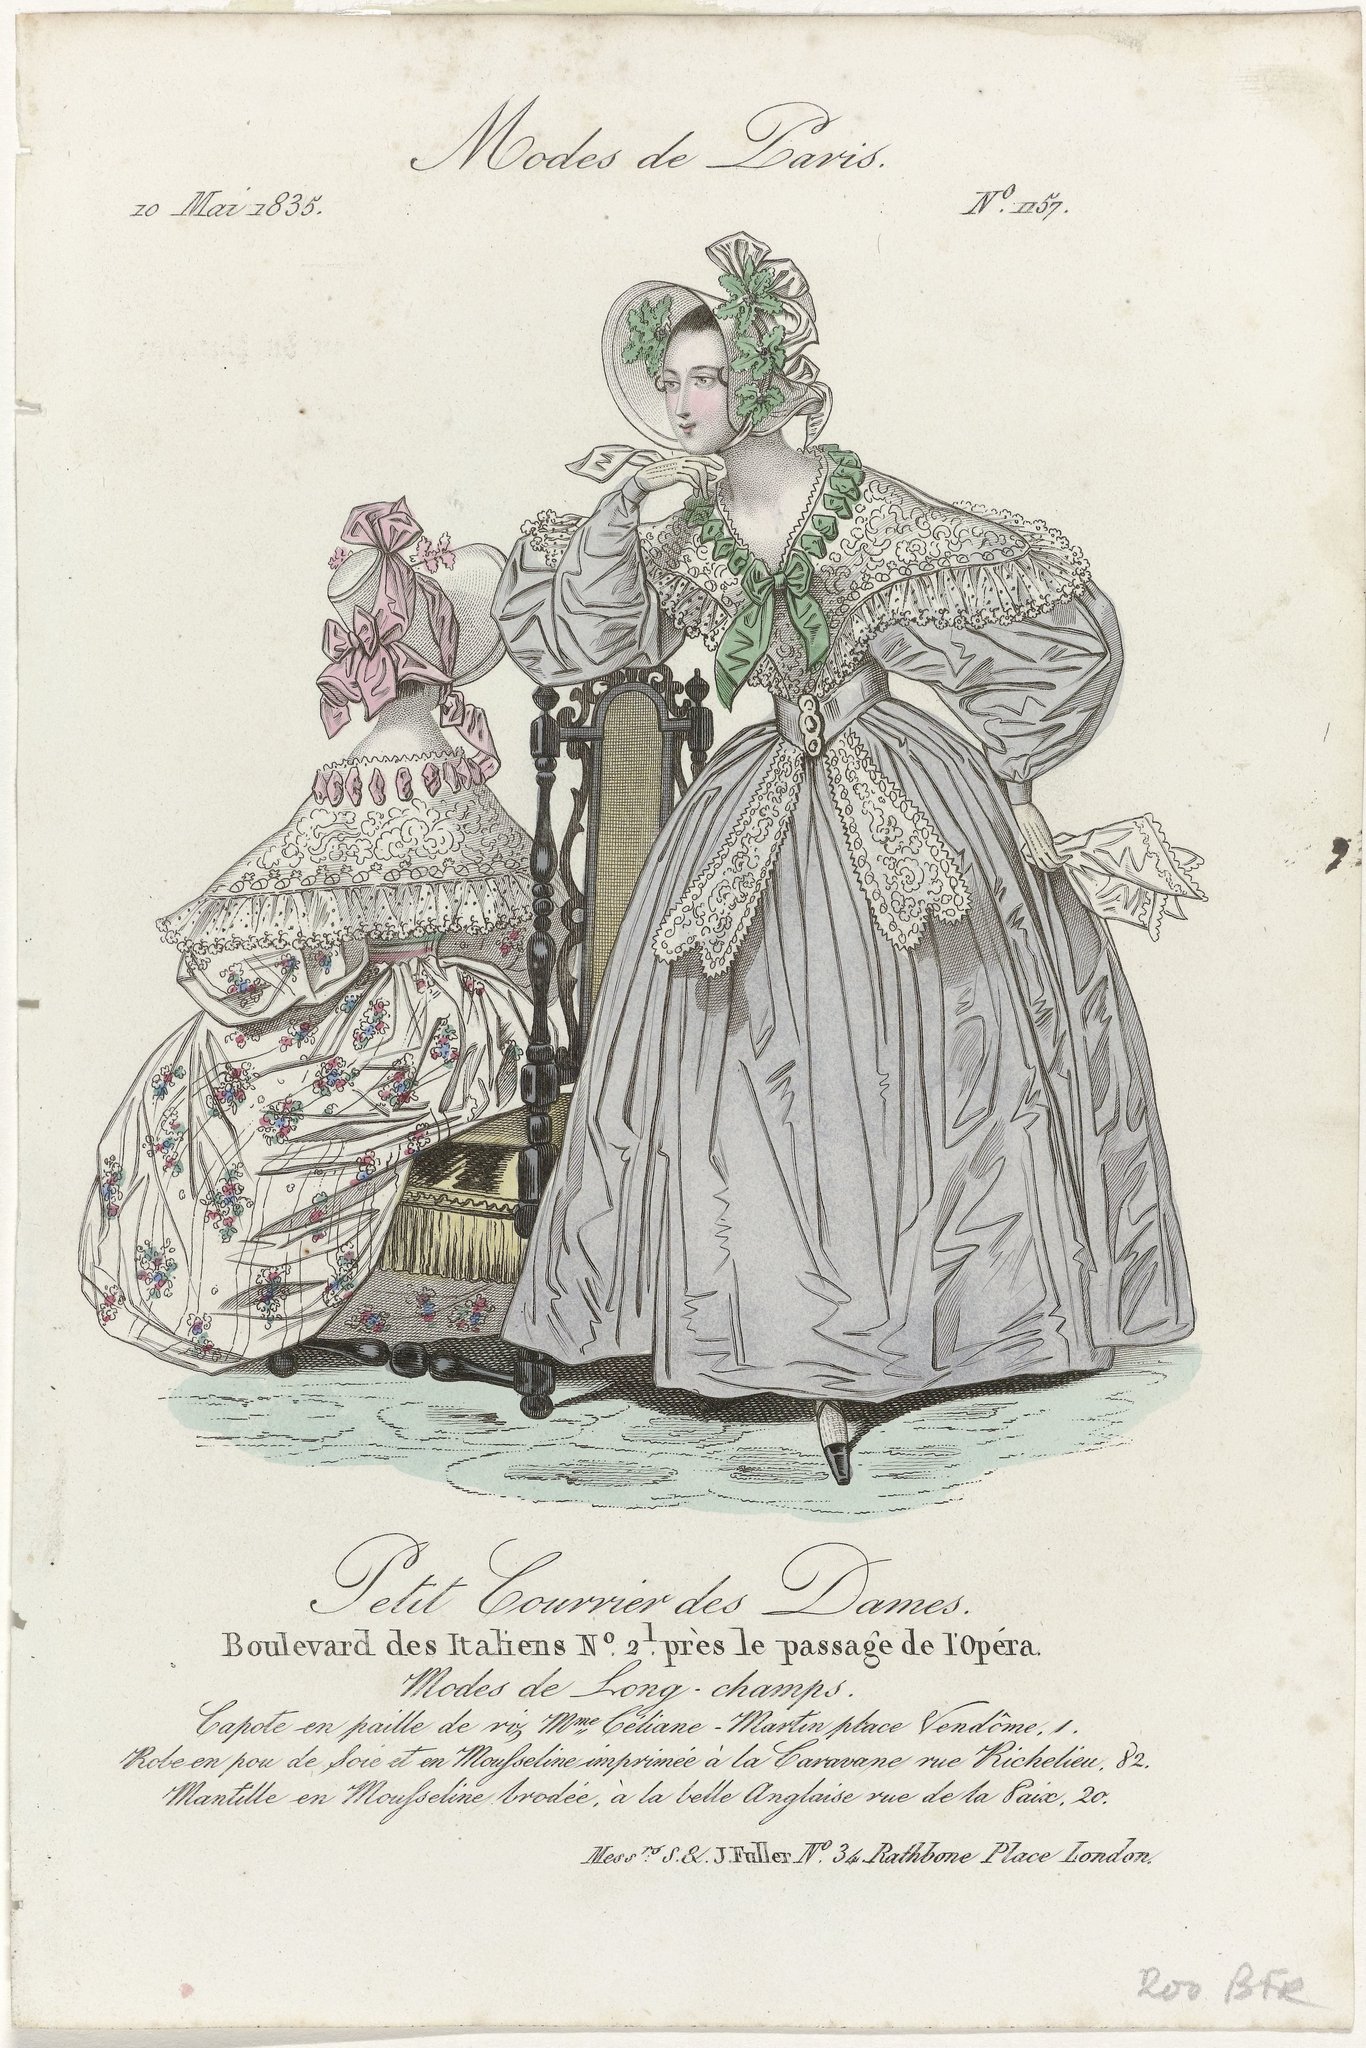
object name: fashion print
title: Petit Courrier des Dames, 10 mai 1835, No. 1157 : Capote en paille de riz (...)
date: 1835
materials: paper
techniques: engraving, hand coloring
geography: paris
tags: handkerchief (+ women's clothes), head-gear (capote) (+ women's clothes), embroidery (ornamentation) (+ women's clothes), clothing for the upper part of the body (mantelet) (+ women's clothes), fashion plates, gloves, mittens, etc. (+ women's clothes), dress, gown (+ women's clothes)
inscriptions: address: ‘Boulevard des Italiens No.2 près le passage de l'Opéra / Mess.rs S.&.J. Fuller No. 34 Rathbone Place London.’, title: ‘Modes de Paris.’, title: ‘Petit Courrier des Dames.’, caption: ‘Capote en paille de riz M"me Céliane - Martin place Vendôme,1. Robe en pou de soie et en Mousseline imprimée à la Caravane rue Richelieu,82. Mantille en Mousseline brodée, à la belle Anglaise rue de la Paix, 20.’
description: 'Capote' van 'paille de riz' van Céliane-Martin. Japon van 'pou de soie' en van bedrukte mousseline, 'à la Caravane'. 'Mantille' van geborduurde mousseline, 'à la belle Anglaise'. Verdere accessoires: handschoenen, zakdoek, ceintuur, schoen met vierkante neus. Prent uit het modetijdschrift Petit Courrier des Dames (1821-1868).